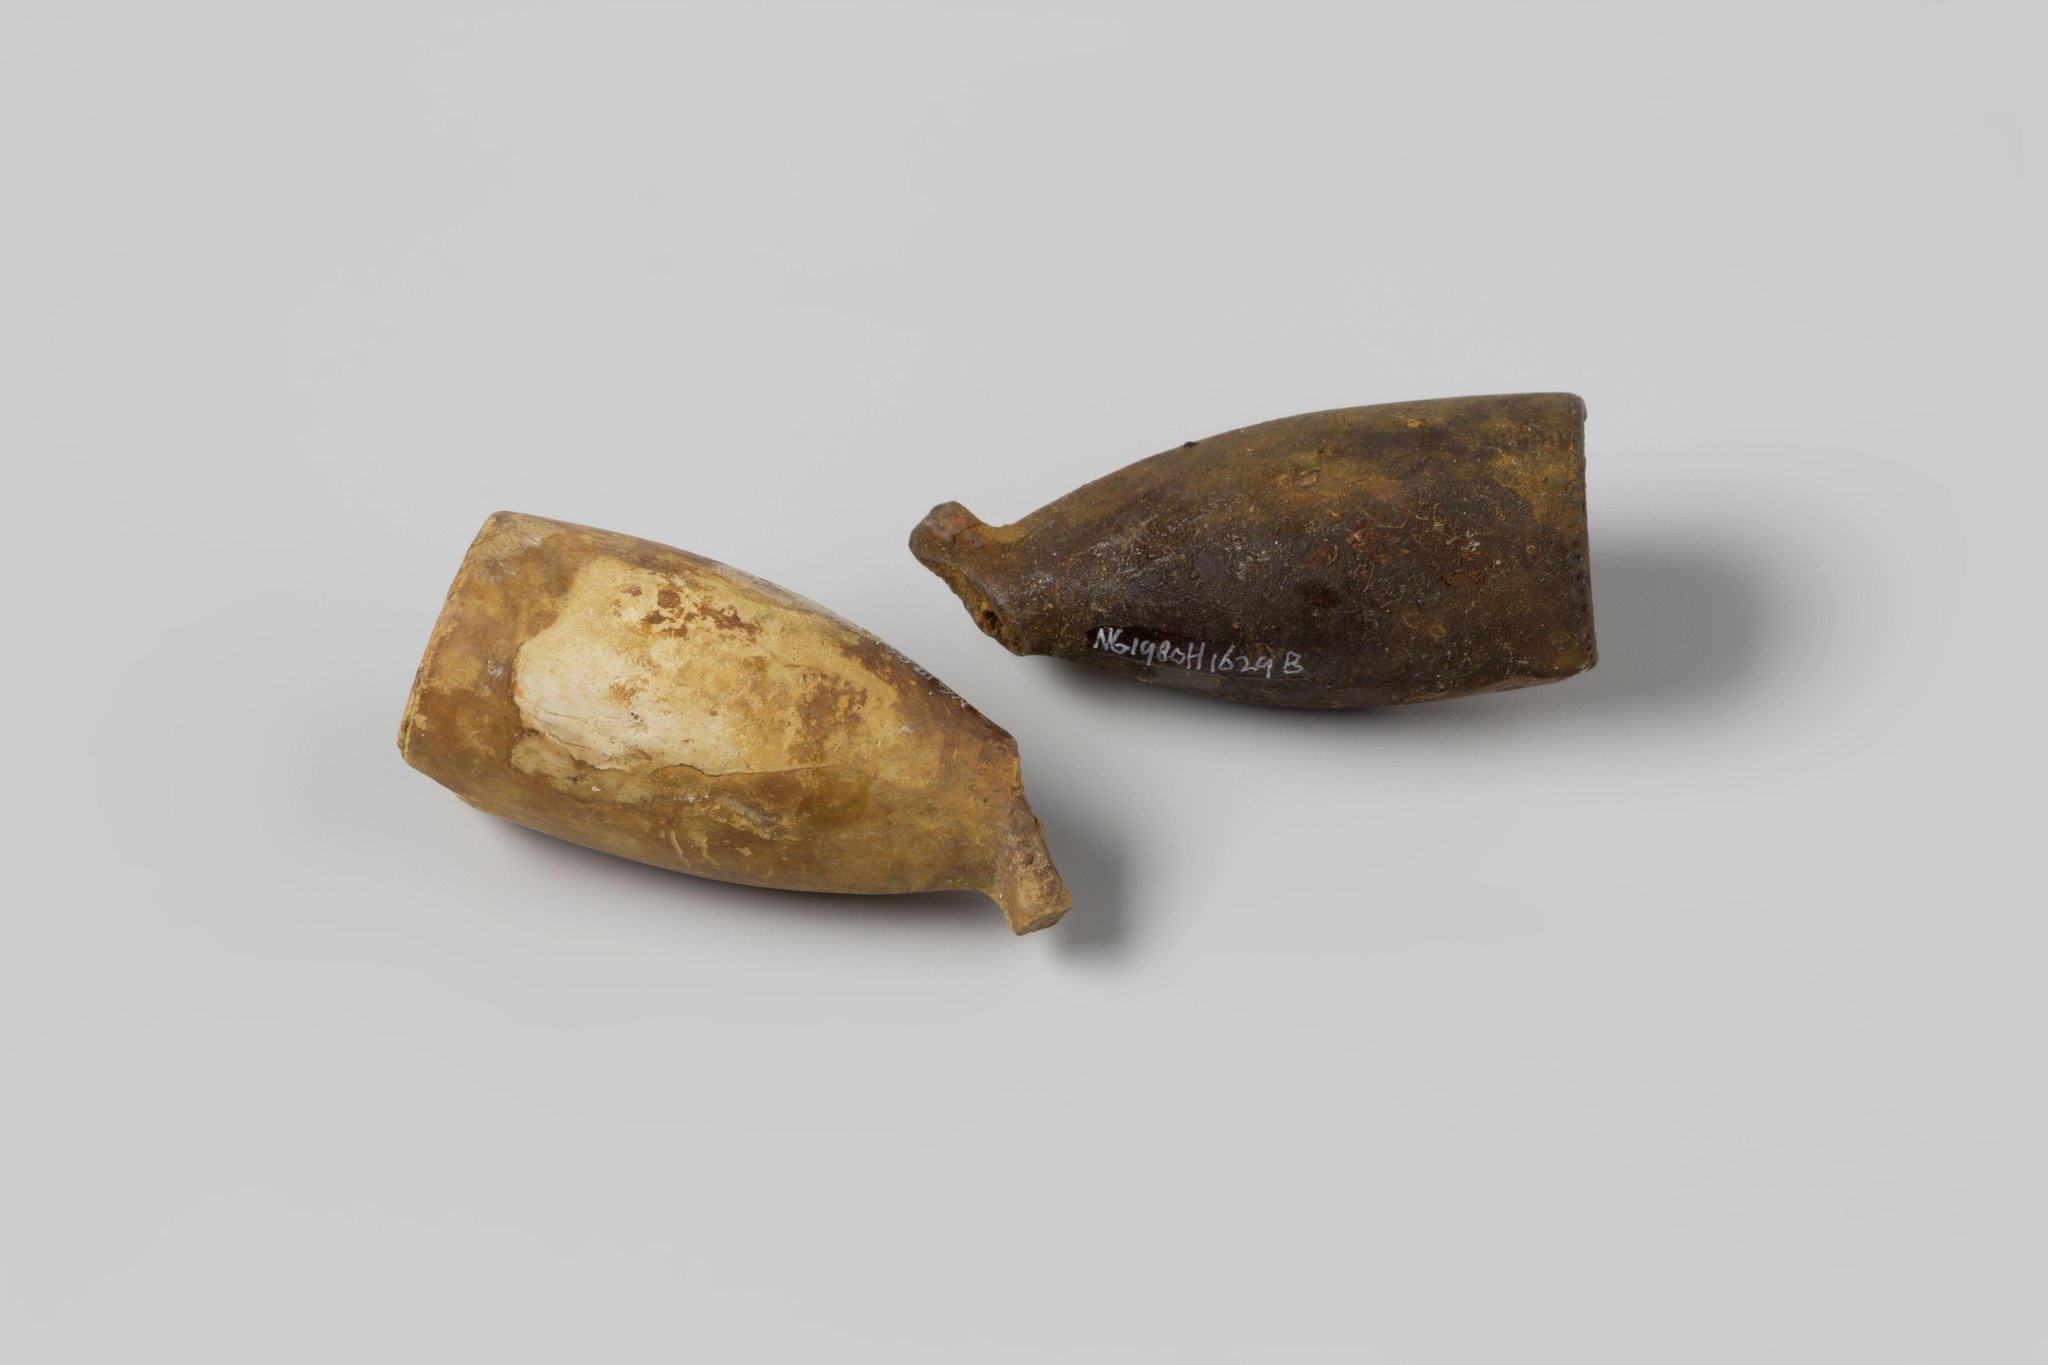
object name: pipe bowl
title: Fragmenten pijpenkoppen uit het wrak van de Oost-Indiëvaarder Hollandia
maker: Anonymous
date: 1700-1743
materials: clay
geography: netherlands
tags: verenigde oostindische compagnie, hollandia (schip), annet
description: Pipe, bowl, heelmark: coat of arms of the city of Amsterdam; fragm, 2hsm1,2.